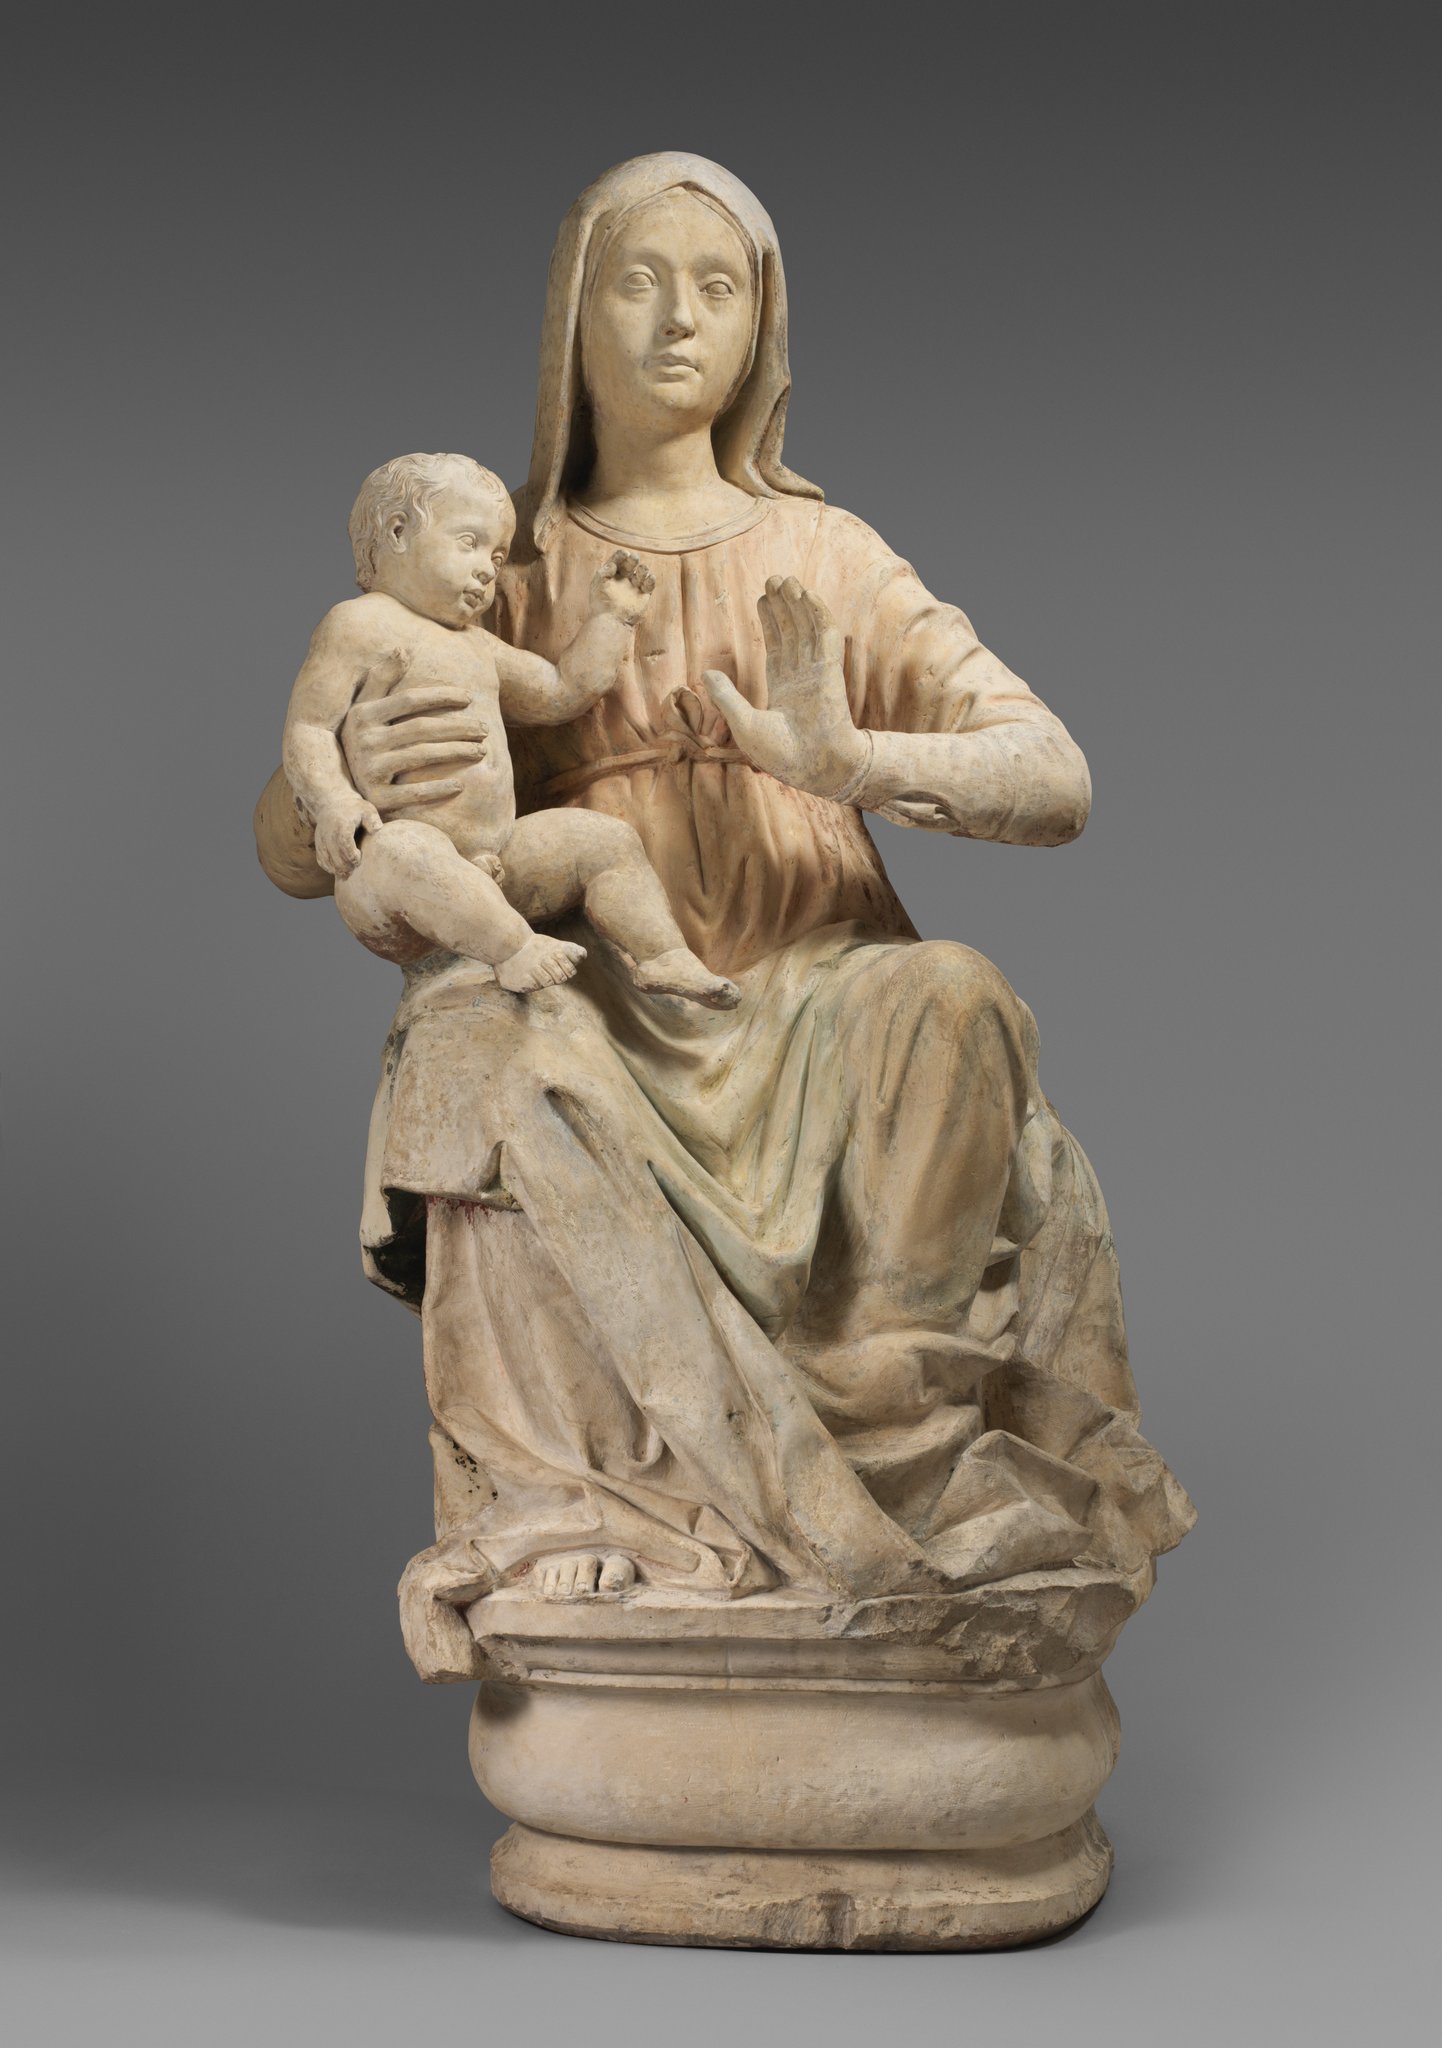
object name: statue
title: Madonna and Child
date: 1460-1480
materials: limestone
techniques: polychromy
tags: madonna and child